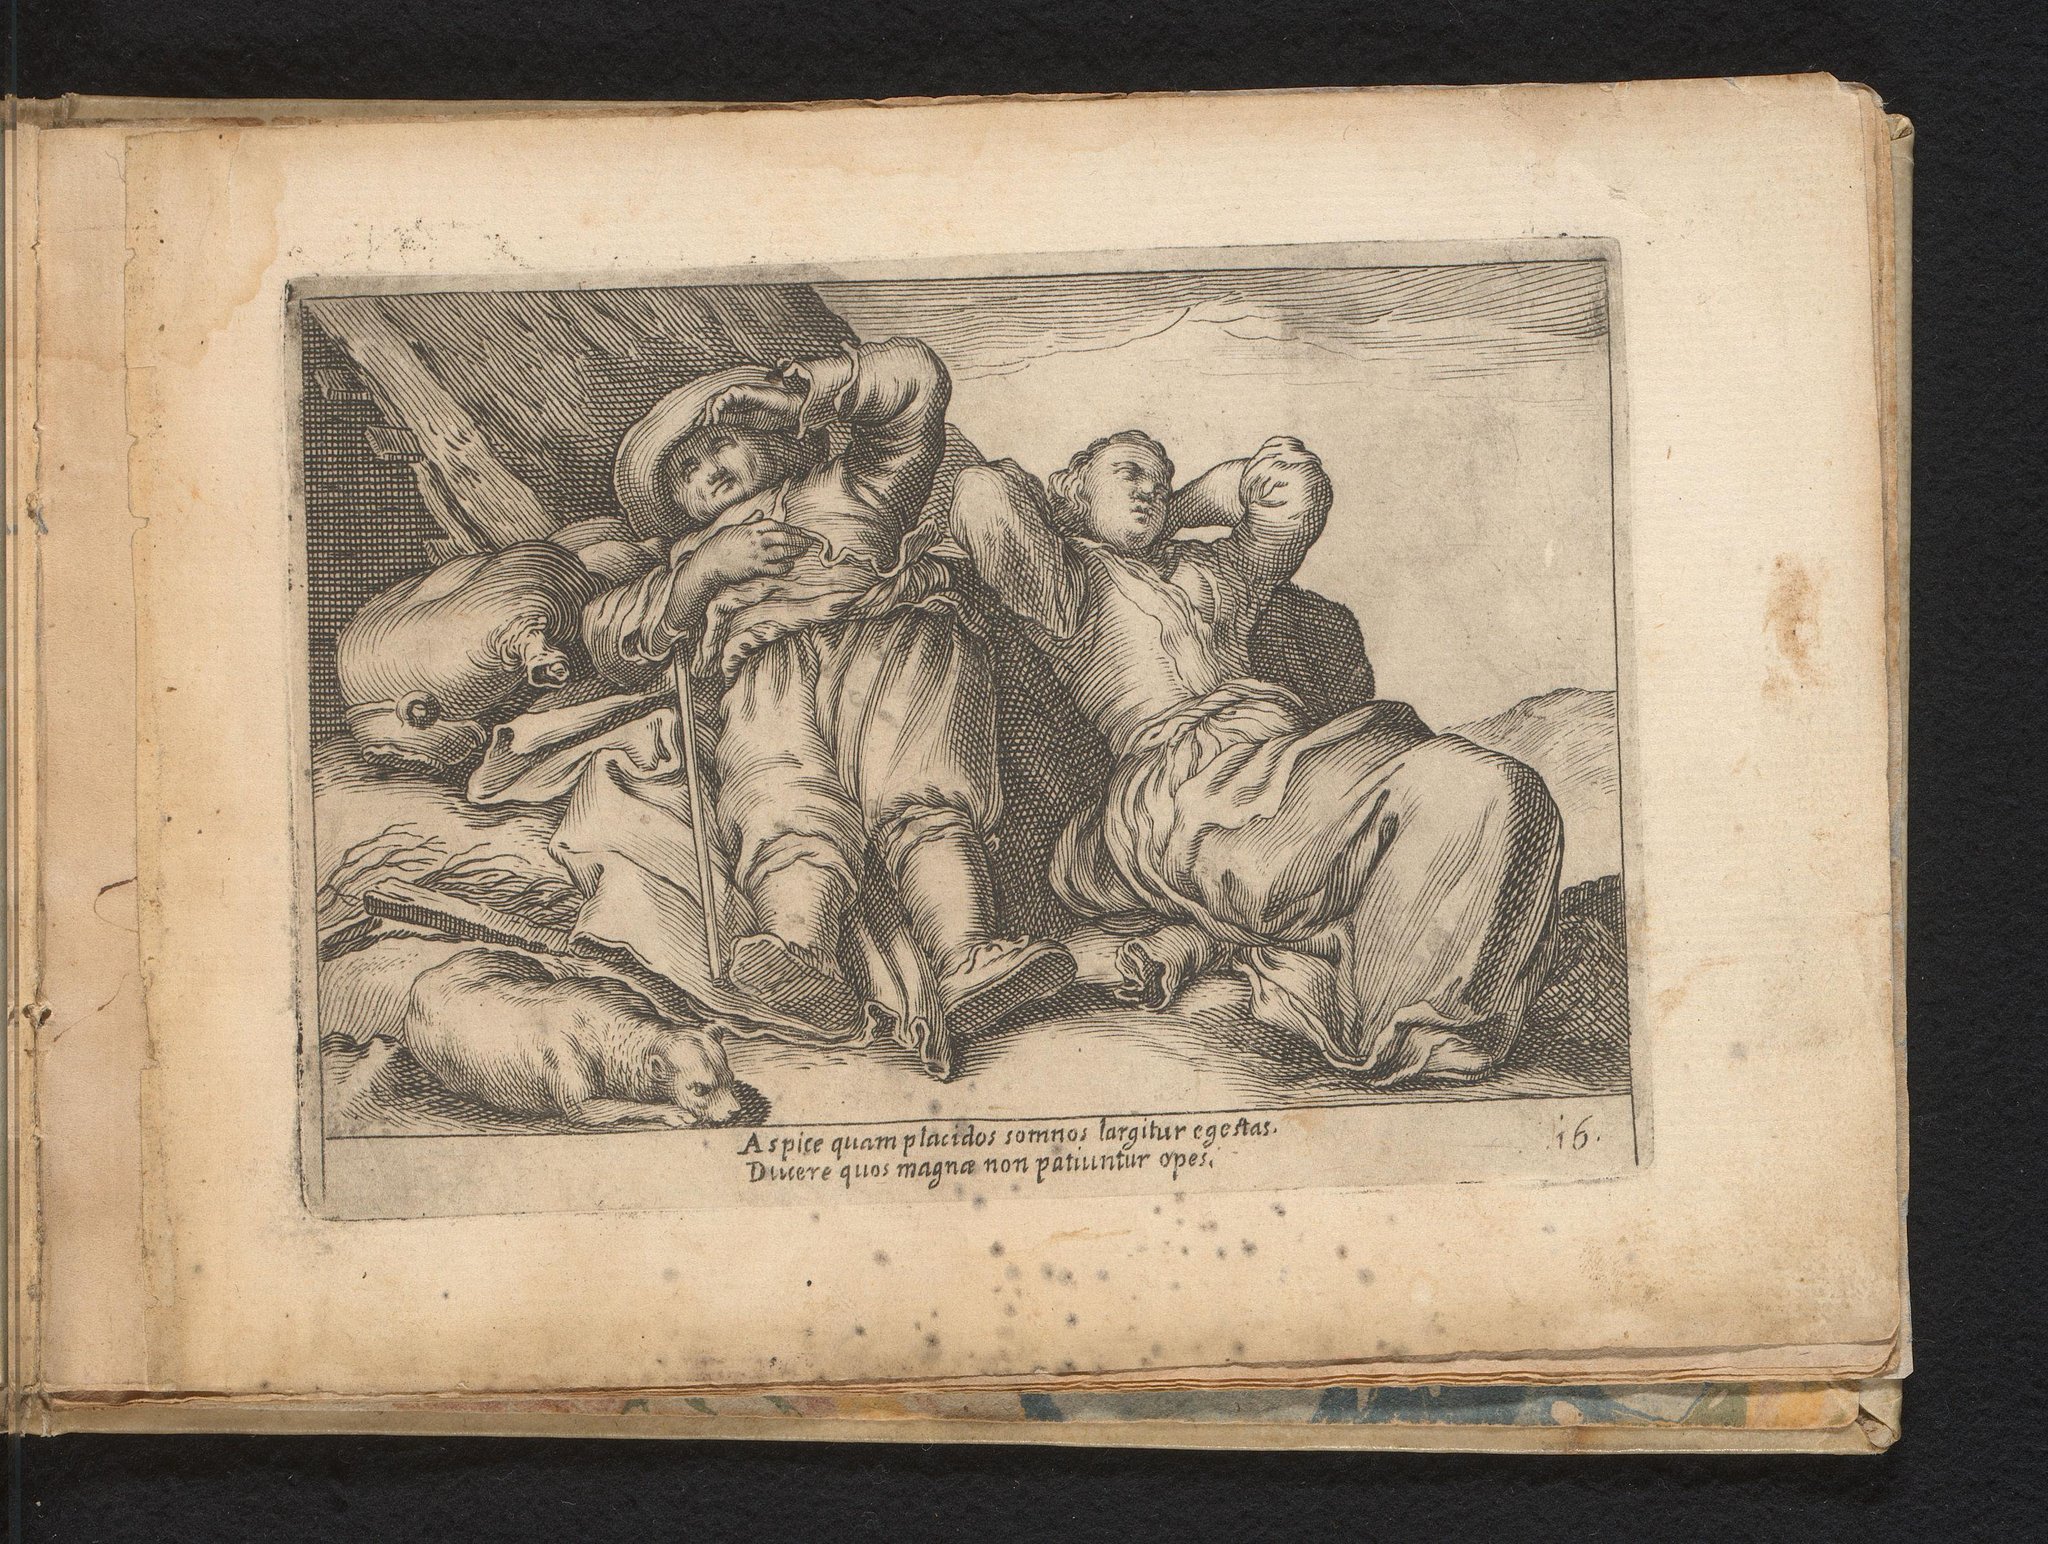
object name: print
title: Twee slapers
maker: Anonymous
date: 1629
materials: ink, paper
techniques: engraving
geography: europe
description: Een man en vrouw liggen uit te rusten. Naast hen een drinkzak en een hond. Met tweeregelig vers in het Latijn in ondermarge. Het betreft de serie getiteld: Otia delectant faciuntq [...]. Kalfsleren band met opschrift en decoratieve kaderlijnen in pen in bruin. Voorin en achterin vier schutbladen van velijn.